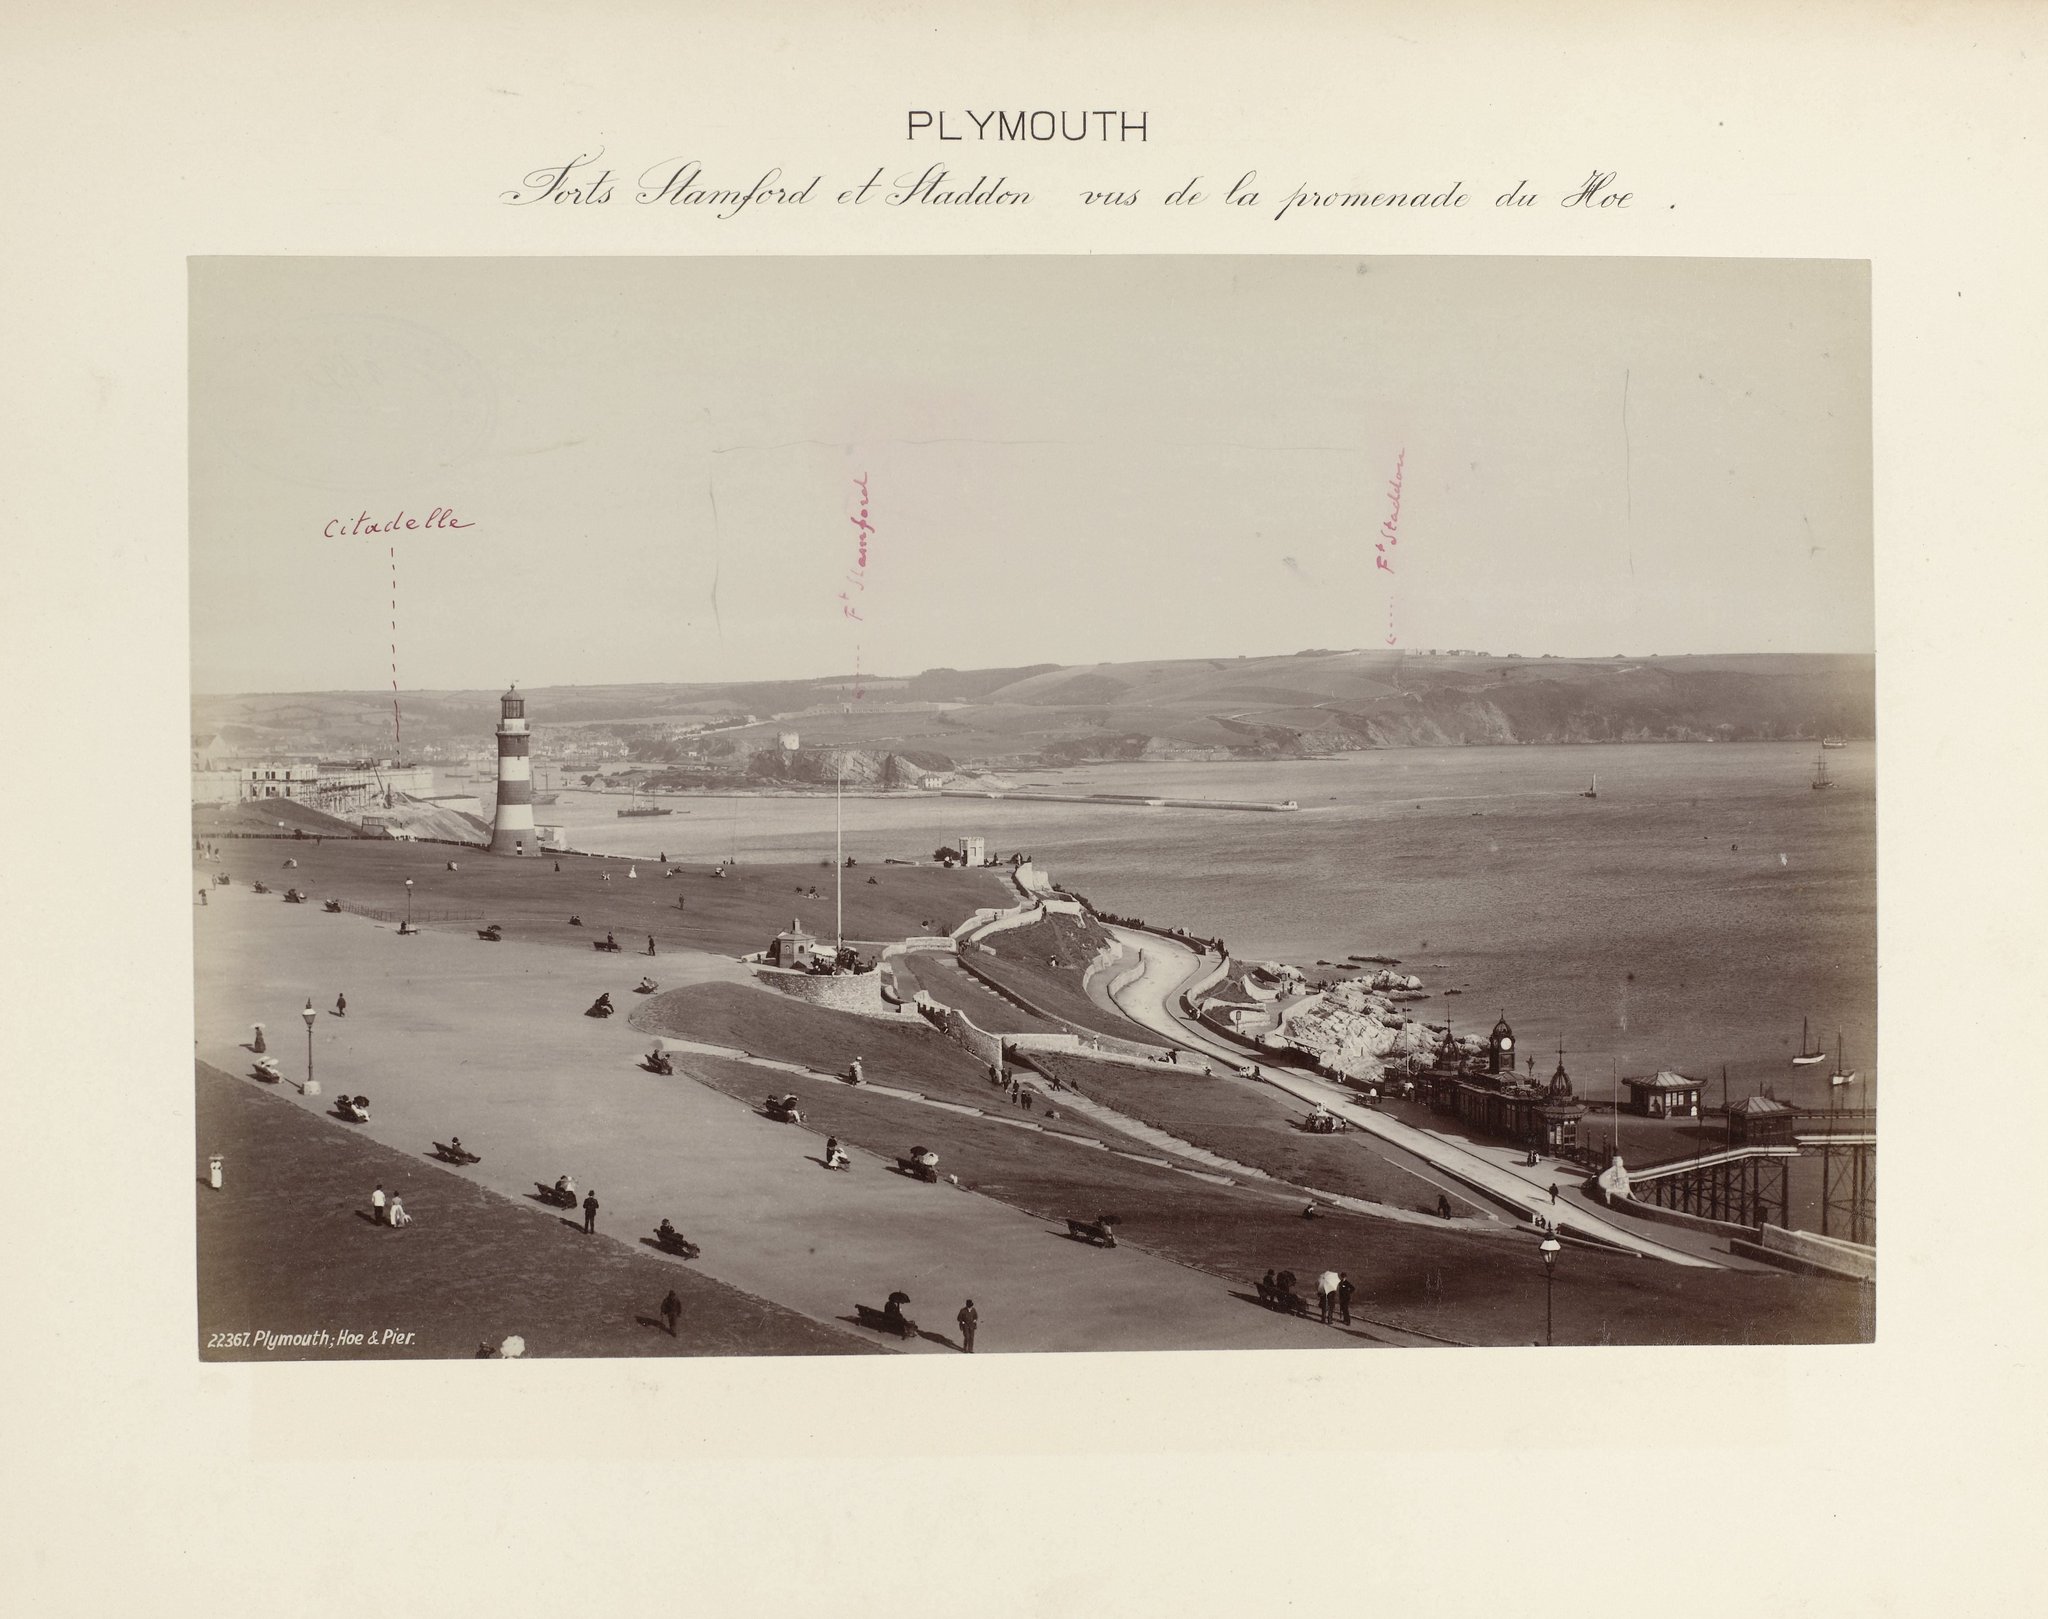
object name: photograph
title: Gezicht op de promenade (Hoe) en pier van Plymouth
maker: Anonymous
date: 1891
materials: cardboard, paper, photographic support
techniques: albumen print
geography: great britain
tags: plymouth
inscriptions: inscription: ‘PLYMOUTH / Forts Stamford et Staddon vus de la promenade du Hoe’, annotation: ‘citadelle // Ft Stamford // Ft Staddon’, inscription: ‘22367. Plymouth; Hoe & Pier’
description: Foto uit een album met 35 topografische foto's van Britse kustplaatsen, waarop in pen militaire verdedigingswerken zijn aangegeven door een Franse militair.